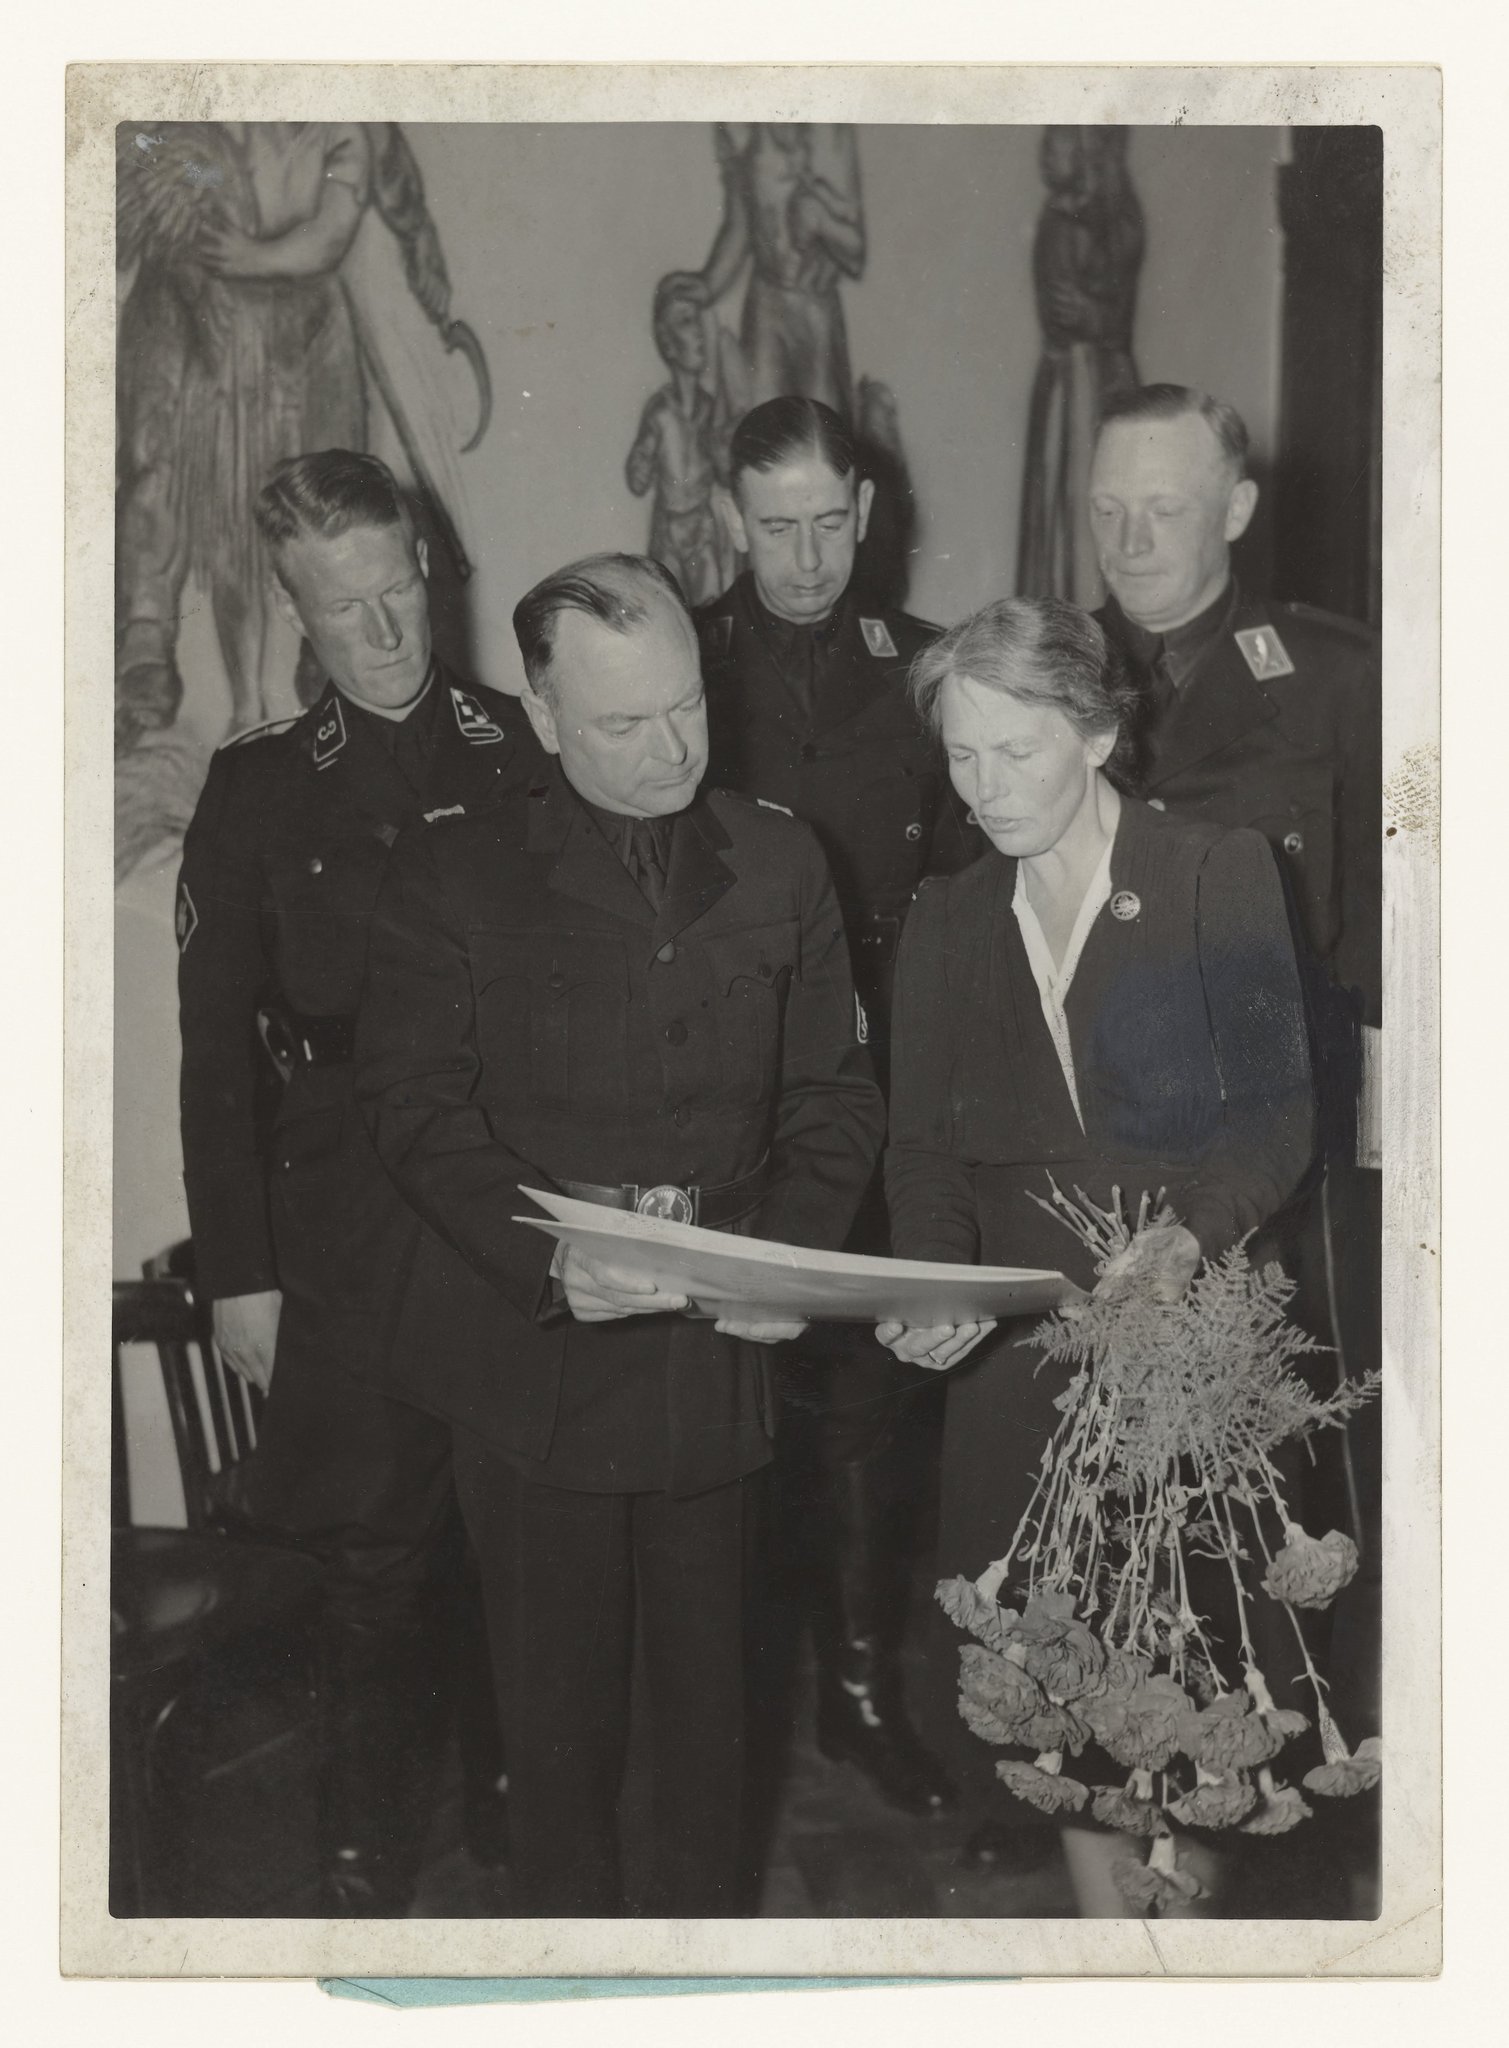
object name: photograph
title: NSB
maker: j.c.m. otto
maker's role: fotograaf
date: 1907-1942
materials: photographic support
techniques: gelatin silver print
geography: amsterdam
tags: the hague, politician, anton adriaan mussert, print, e.g.: engraving, etching, lithograph, amsterdam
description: Mussert ontvangt een ets, die hem wordt aangeboden door mevrouw de Ruiter-van Lankeren Mathes tijdens zijn bezoek aan de provincie Noord-Holland. Mevrouw de Ruiter is de leidster van de NSVO, Nationaal Socialistische Vrouwen Organisatie. Mussert krijgt dit cadeau in het NSVO huis in Amsterdam. Achter Mussert drie NSBers, links Wim Heubel, Nederlandse SSer en broer van de Zwarte Weduwe Rost van Tonningen. Op de muur een versiering met vrouwen.